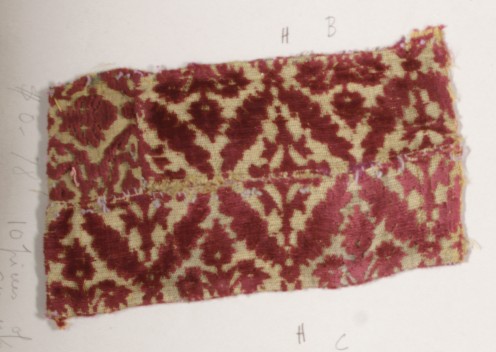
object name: fragment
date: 1701-1800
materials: metal thread, silk